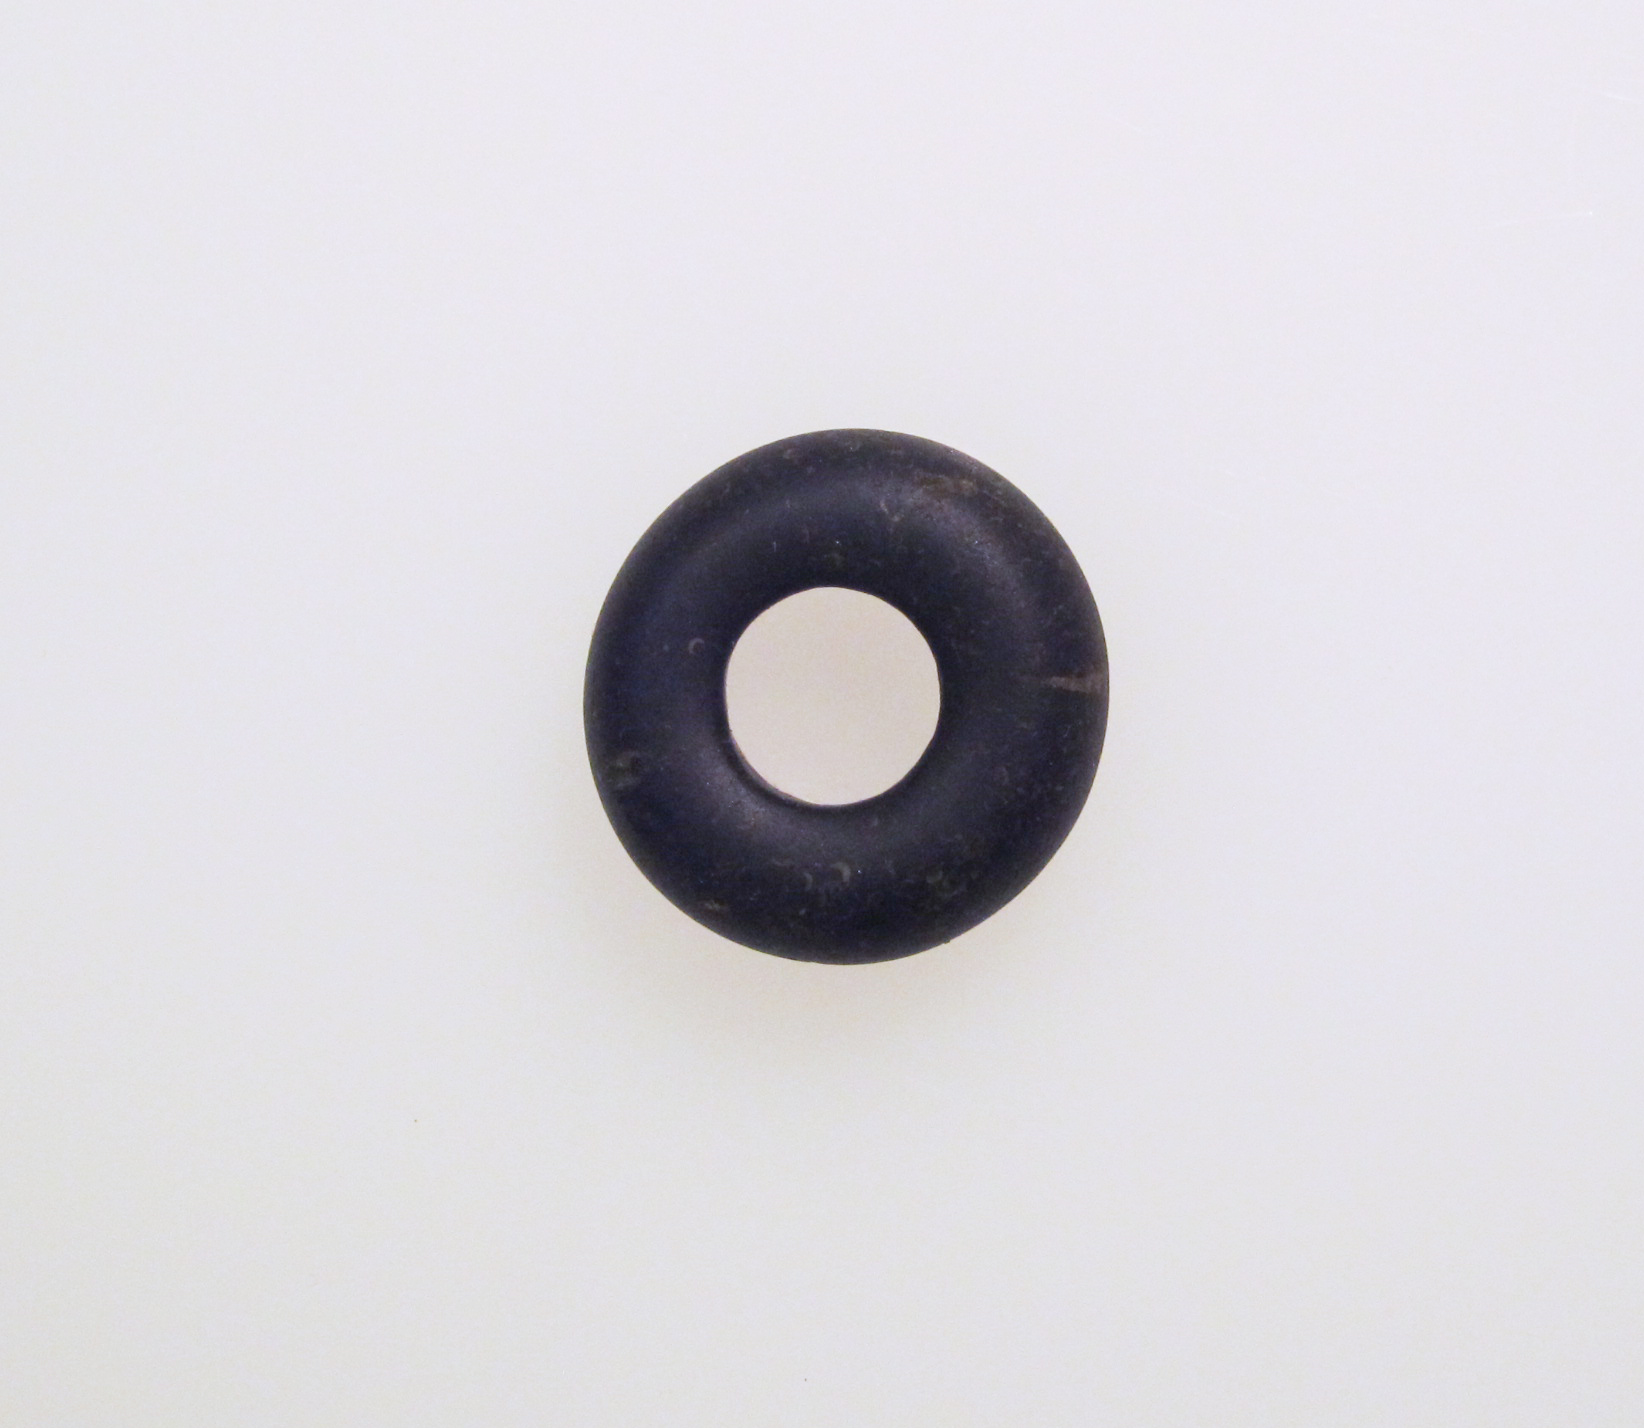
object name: bead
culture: roman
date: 670 BCE-330 CE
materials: glass